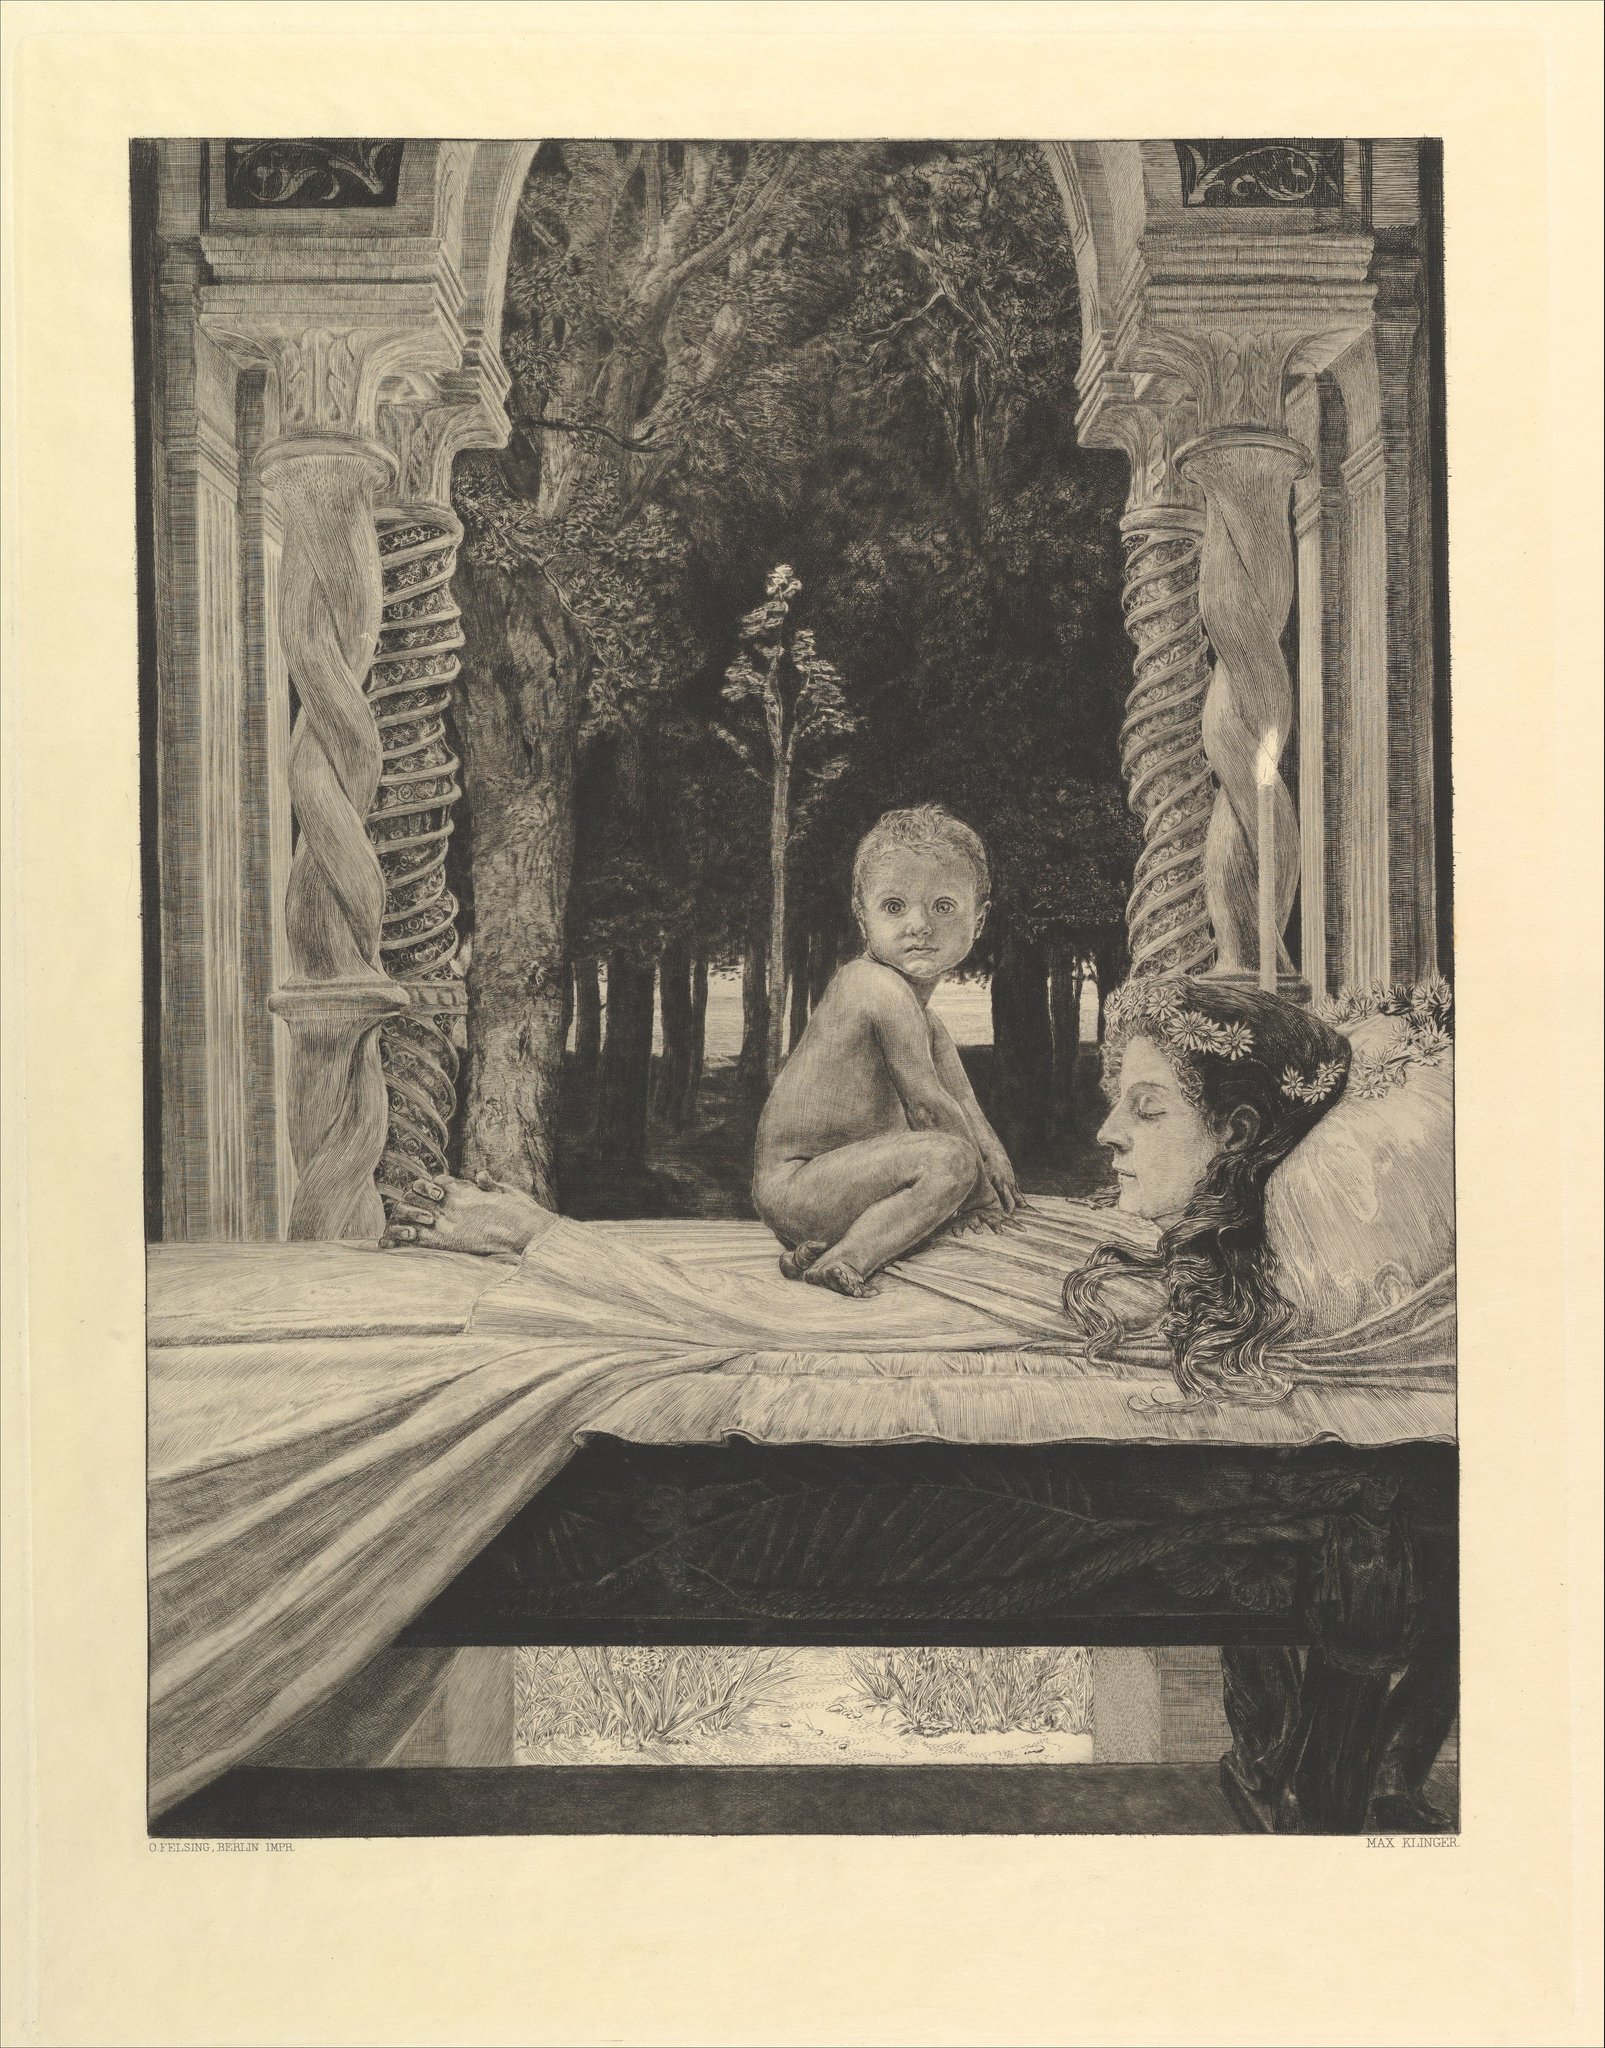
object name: print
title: Tote Mutter, from the series Vom Tode Zweiter Teil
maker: max klinger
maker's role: artist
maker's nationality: german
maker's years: 1857-1920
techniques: aquatint, etching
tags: children,women,death